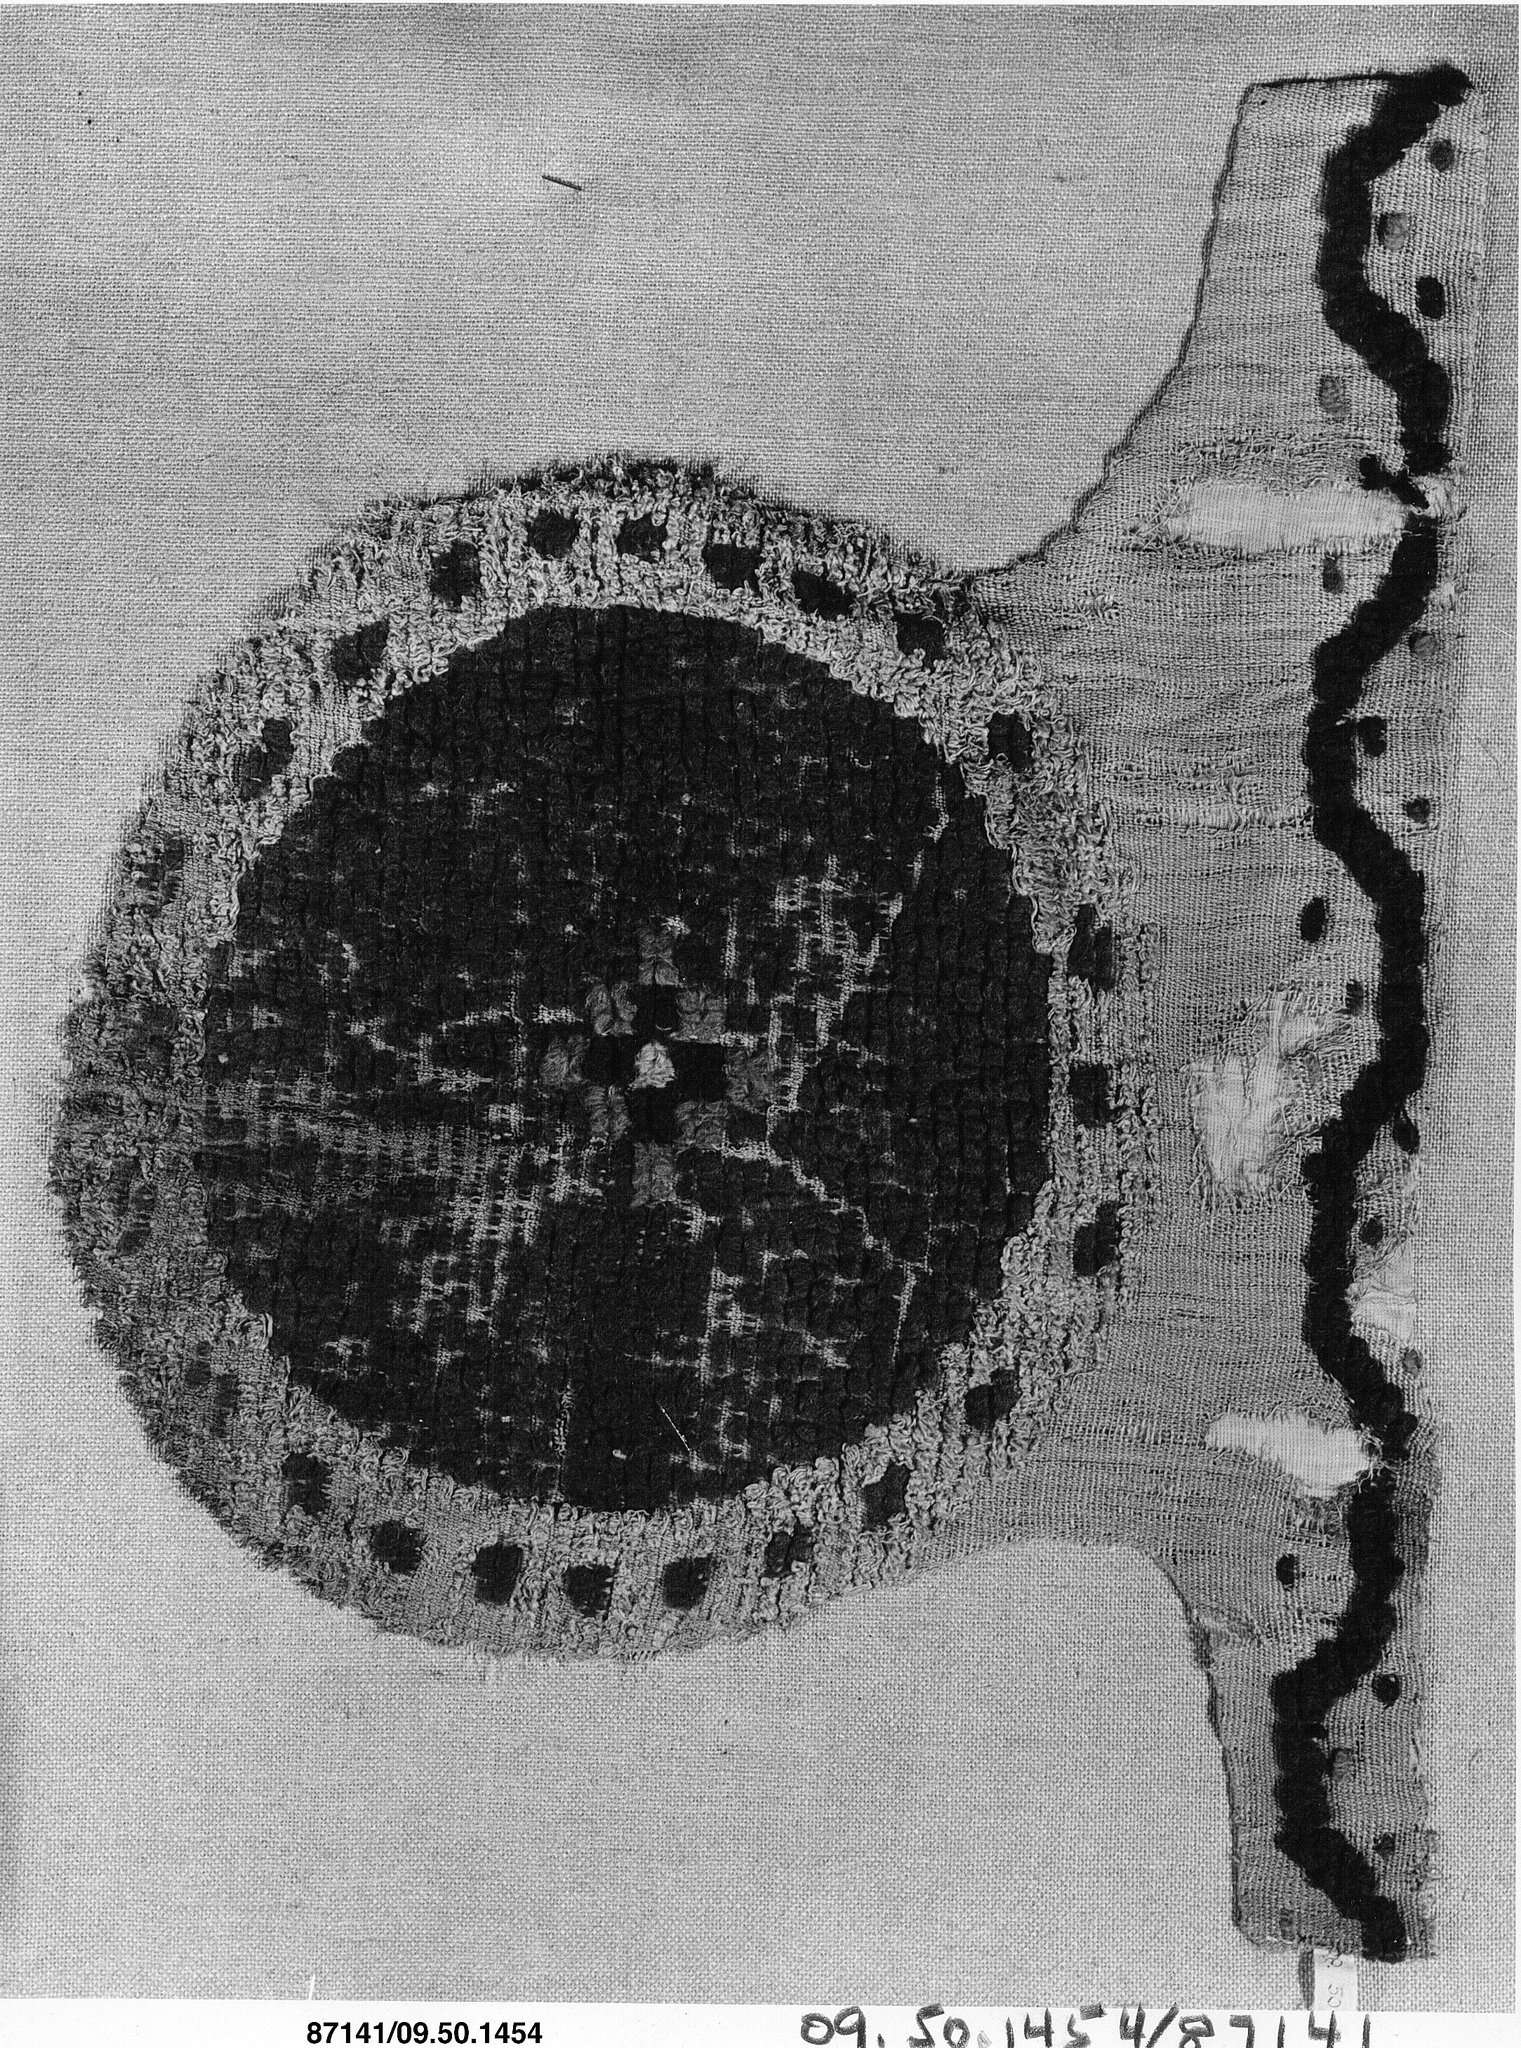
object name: roundel and band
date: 401-500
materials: linen, wool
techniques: weave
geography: egypt